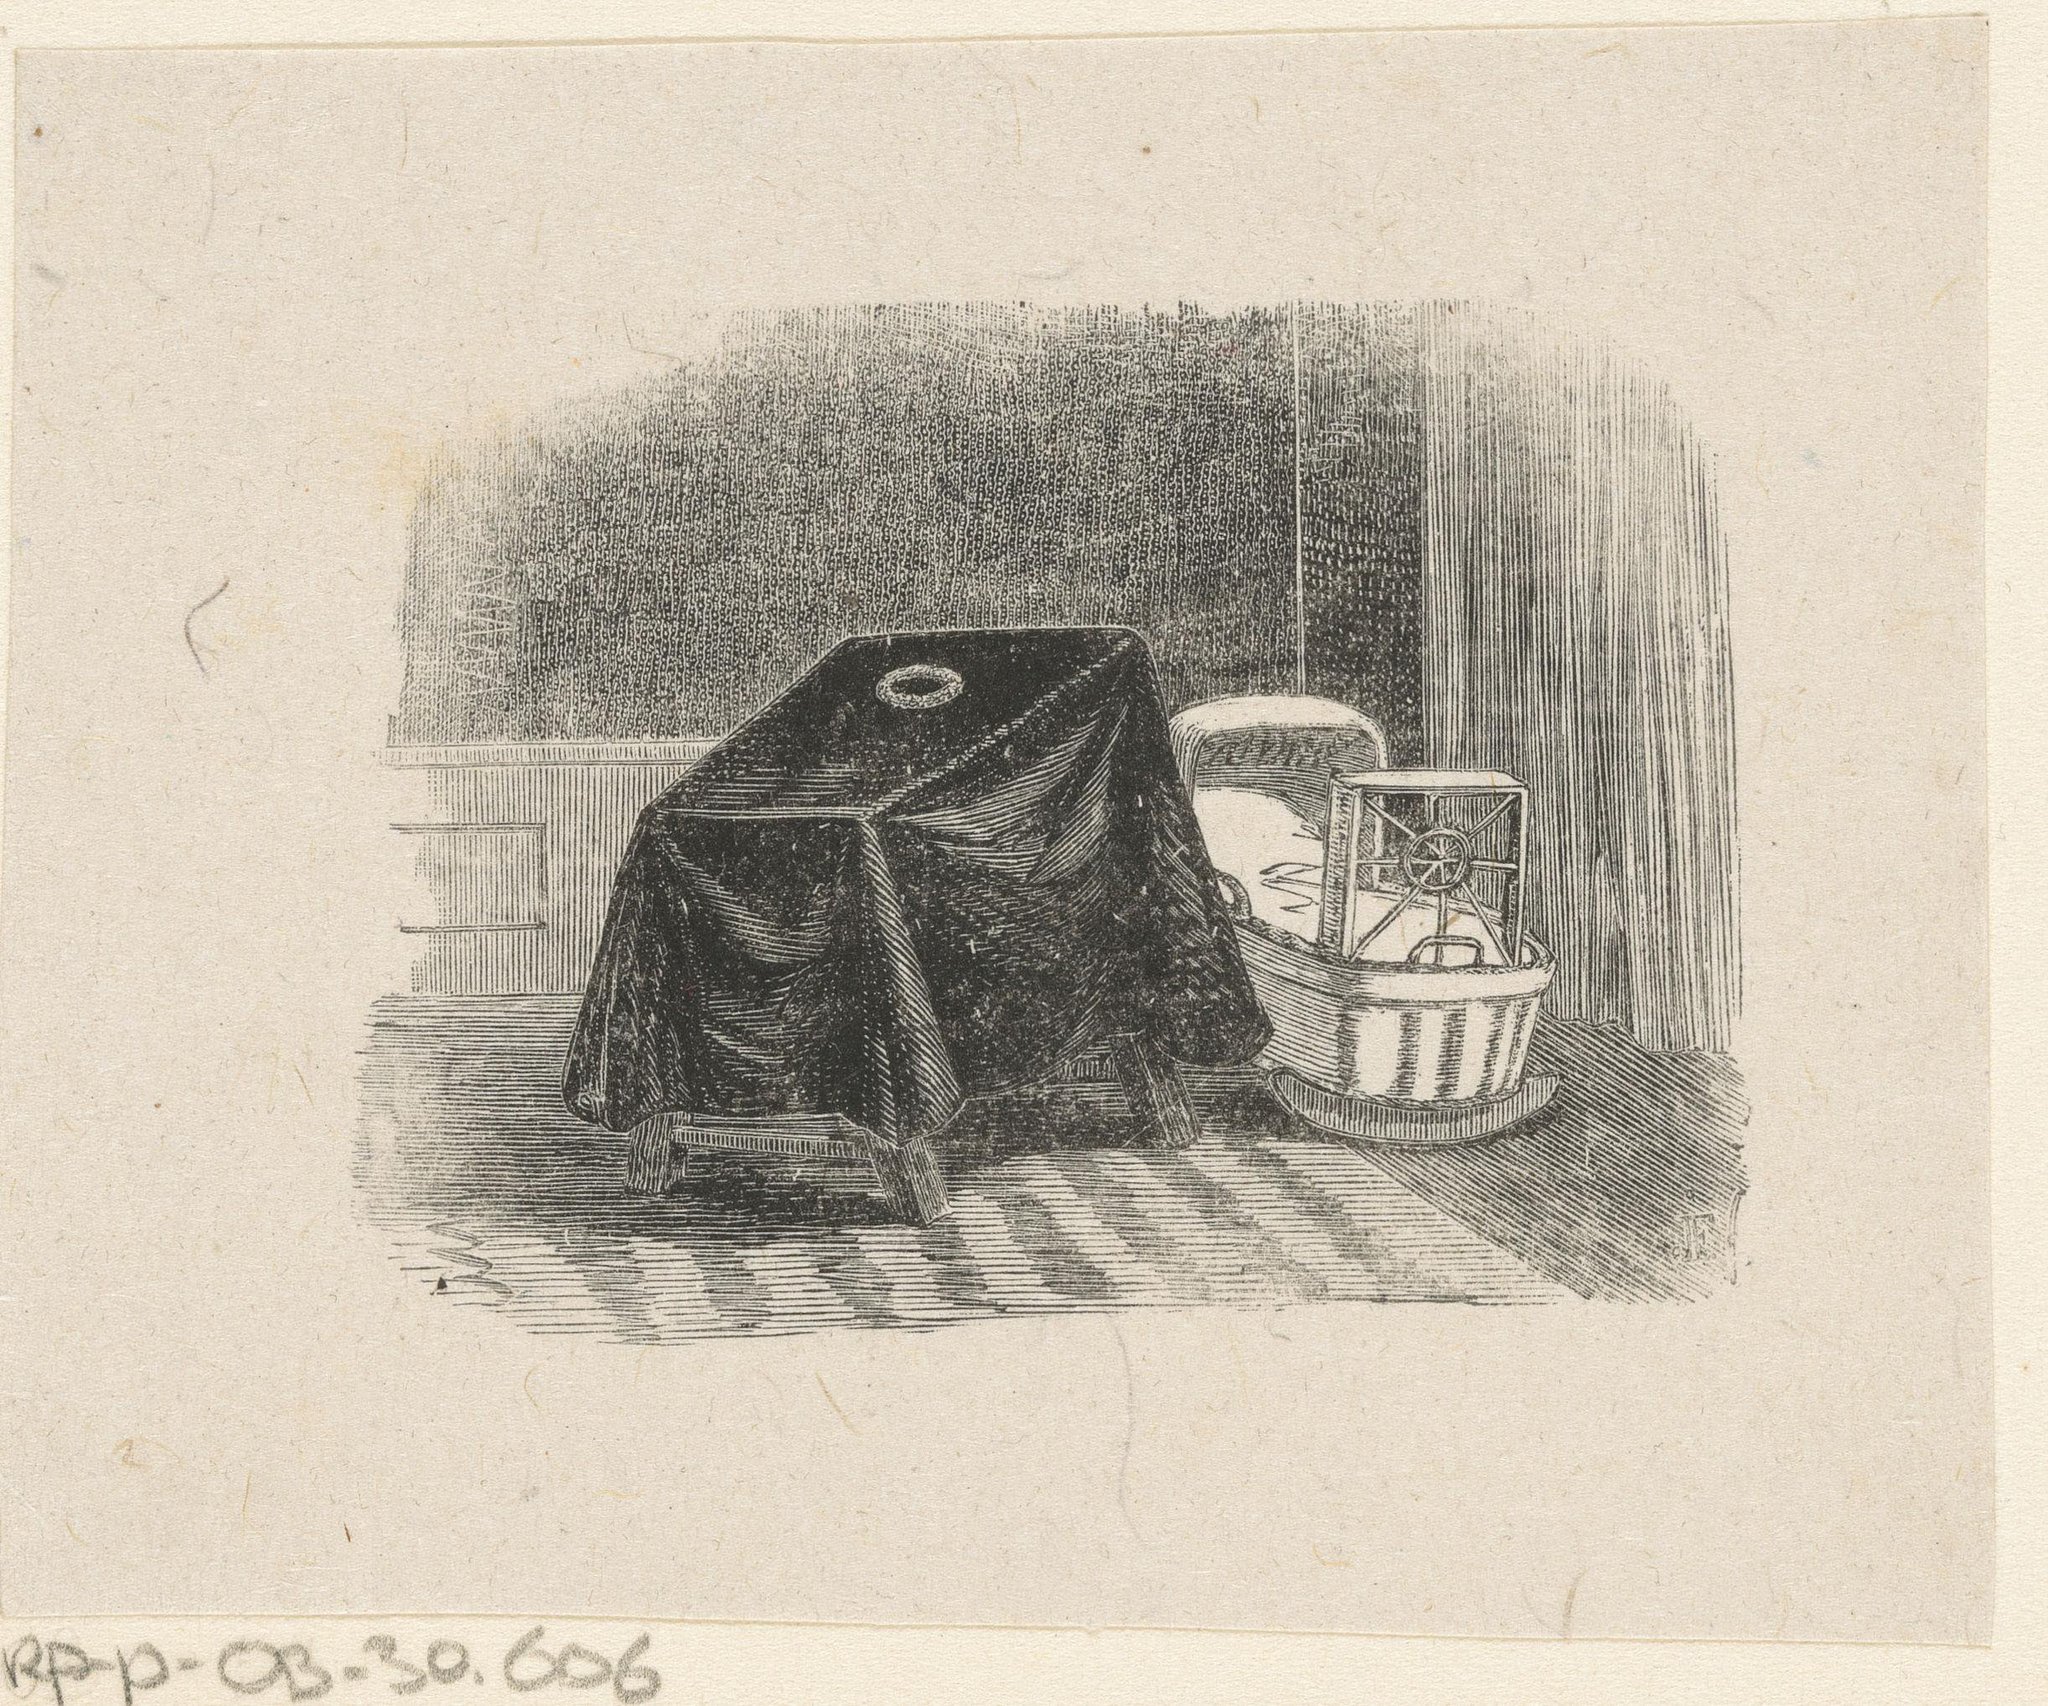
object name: print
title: Zwarte doodskist naast een witte wieg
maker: isaac weissenbruch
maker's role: print maker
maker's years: 1826-1912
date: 1836-1912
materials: paper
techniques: engraving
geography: netherlands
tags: coffin, cradle, crib